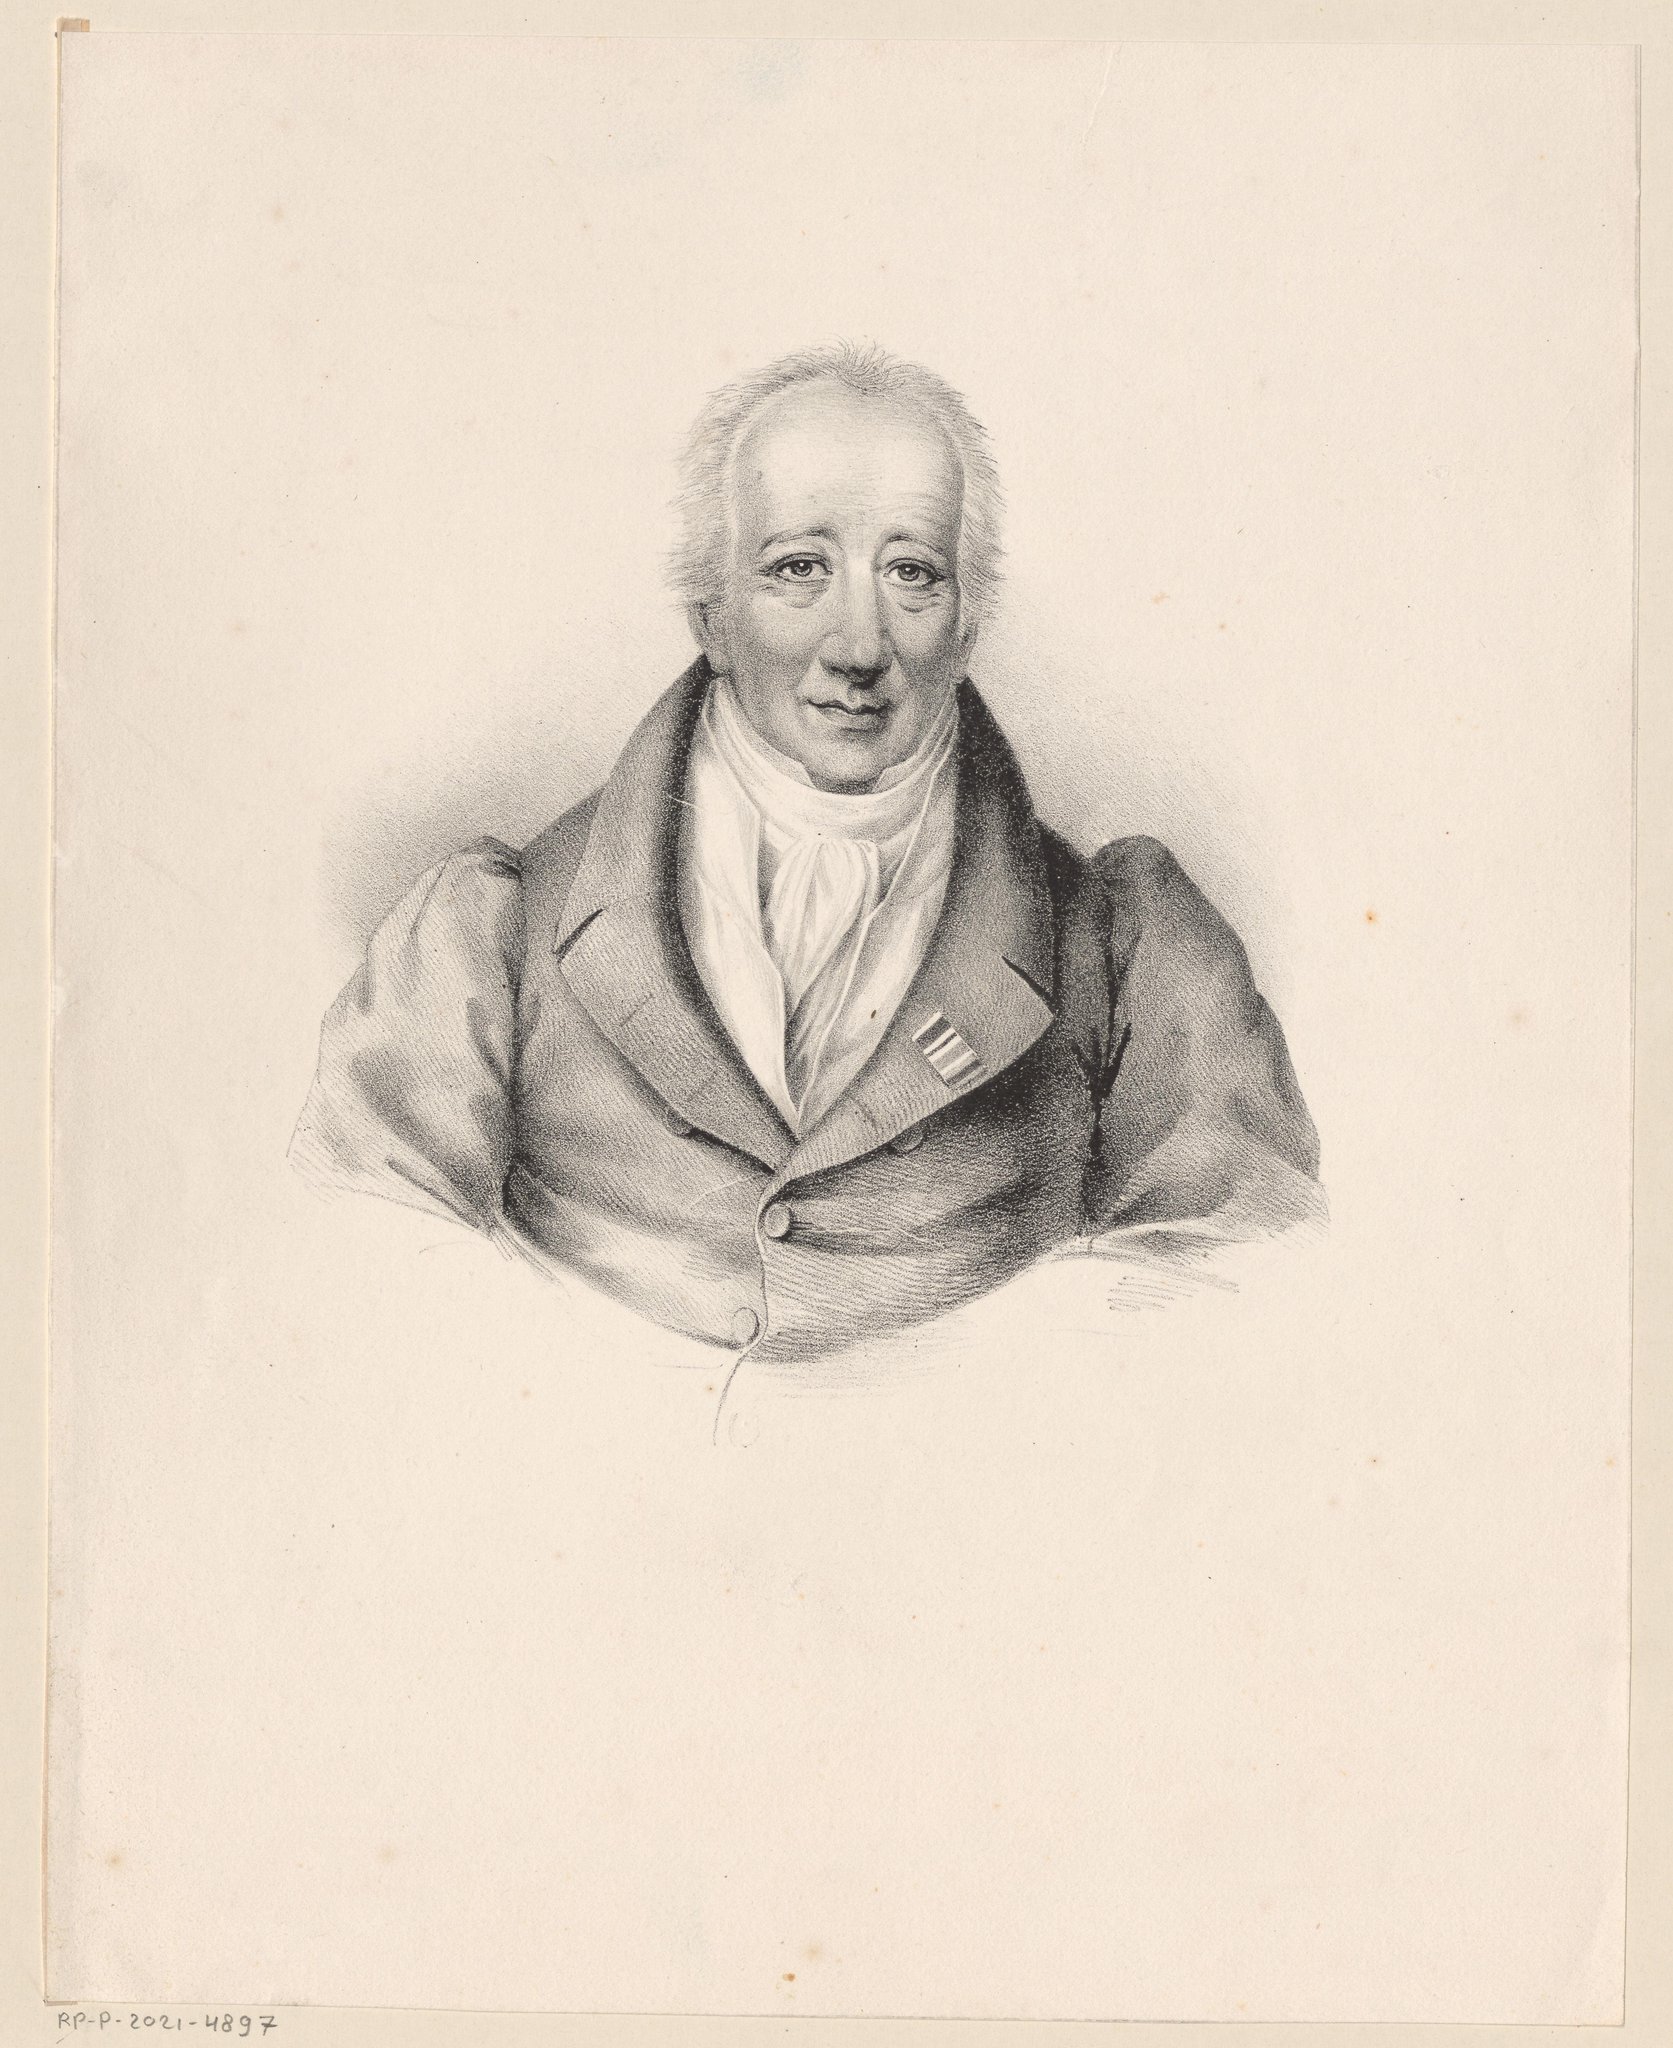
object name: print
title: Portret van mogelijk Jan Willem Hogguer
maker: Anonymous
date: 1825-1874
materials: paper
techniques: lithograph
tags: historical persons